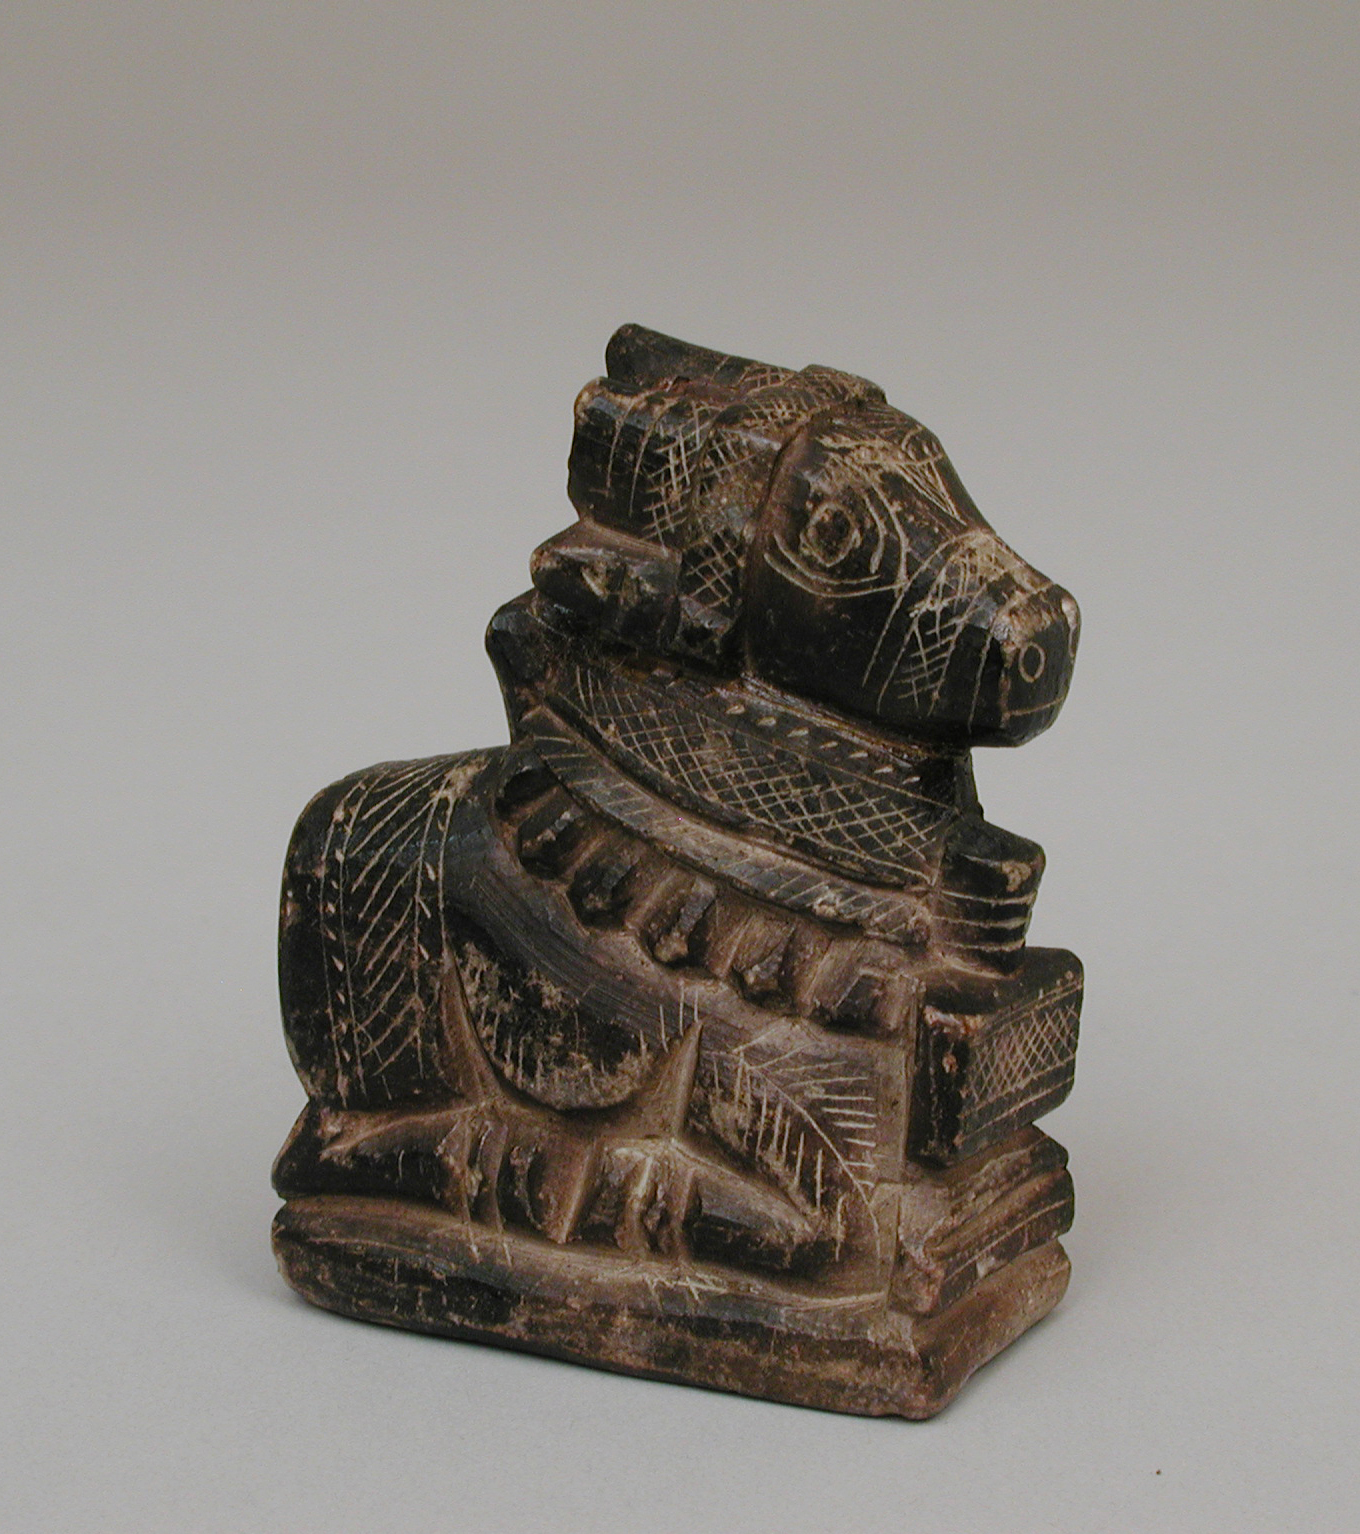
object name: chessman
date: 1701-1900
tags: chess,horses,games